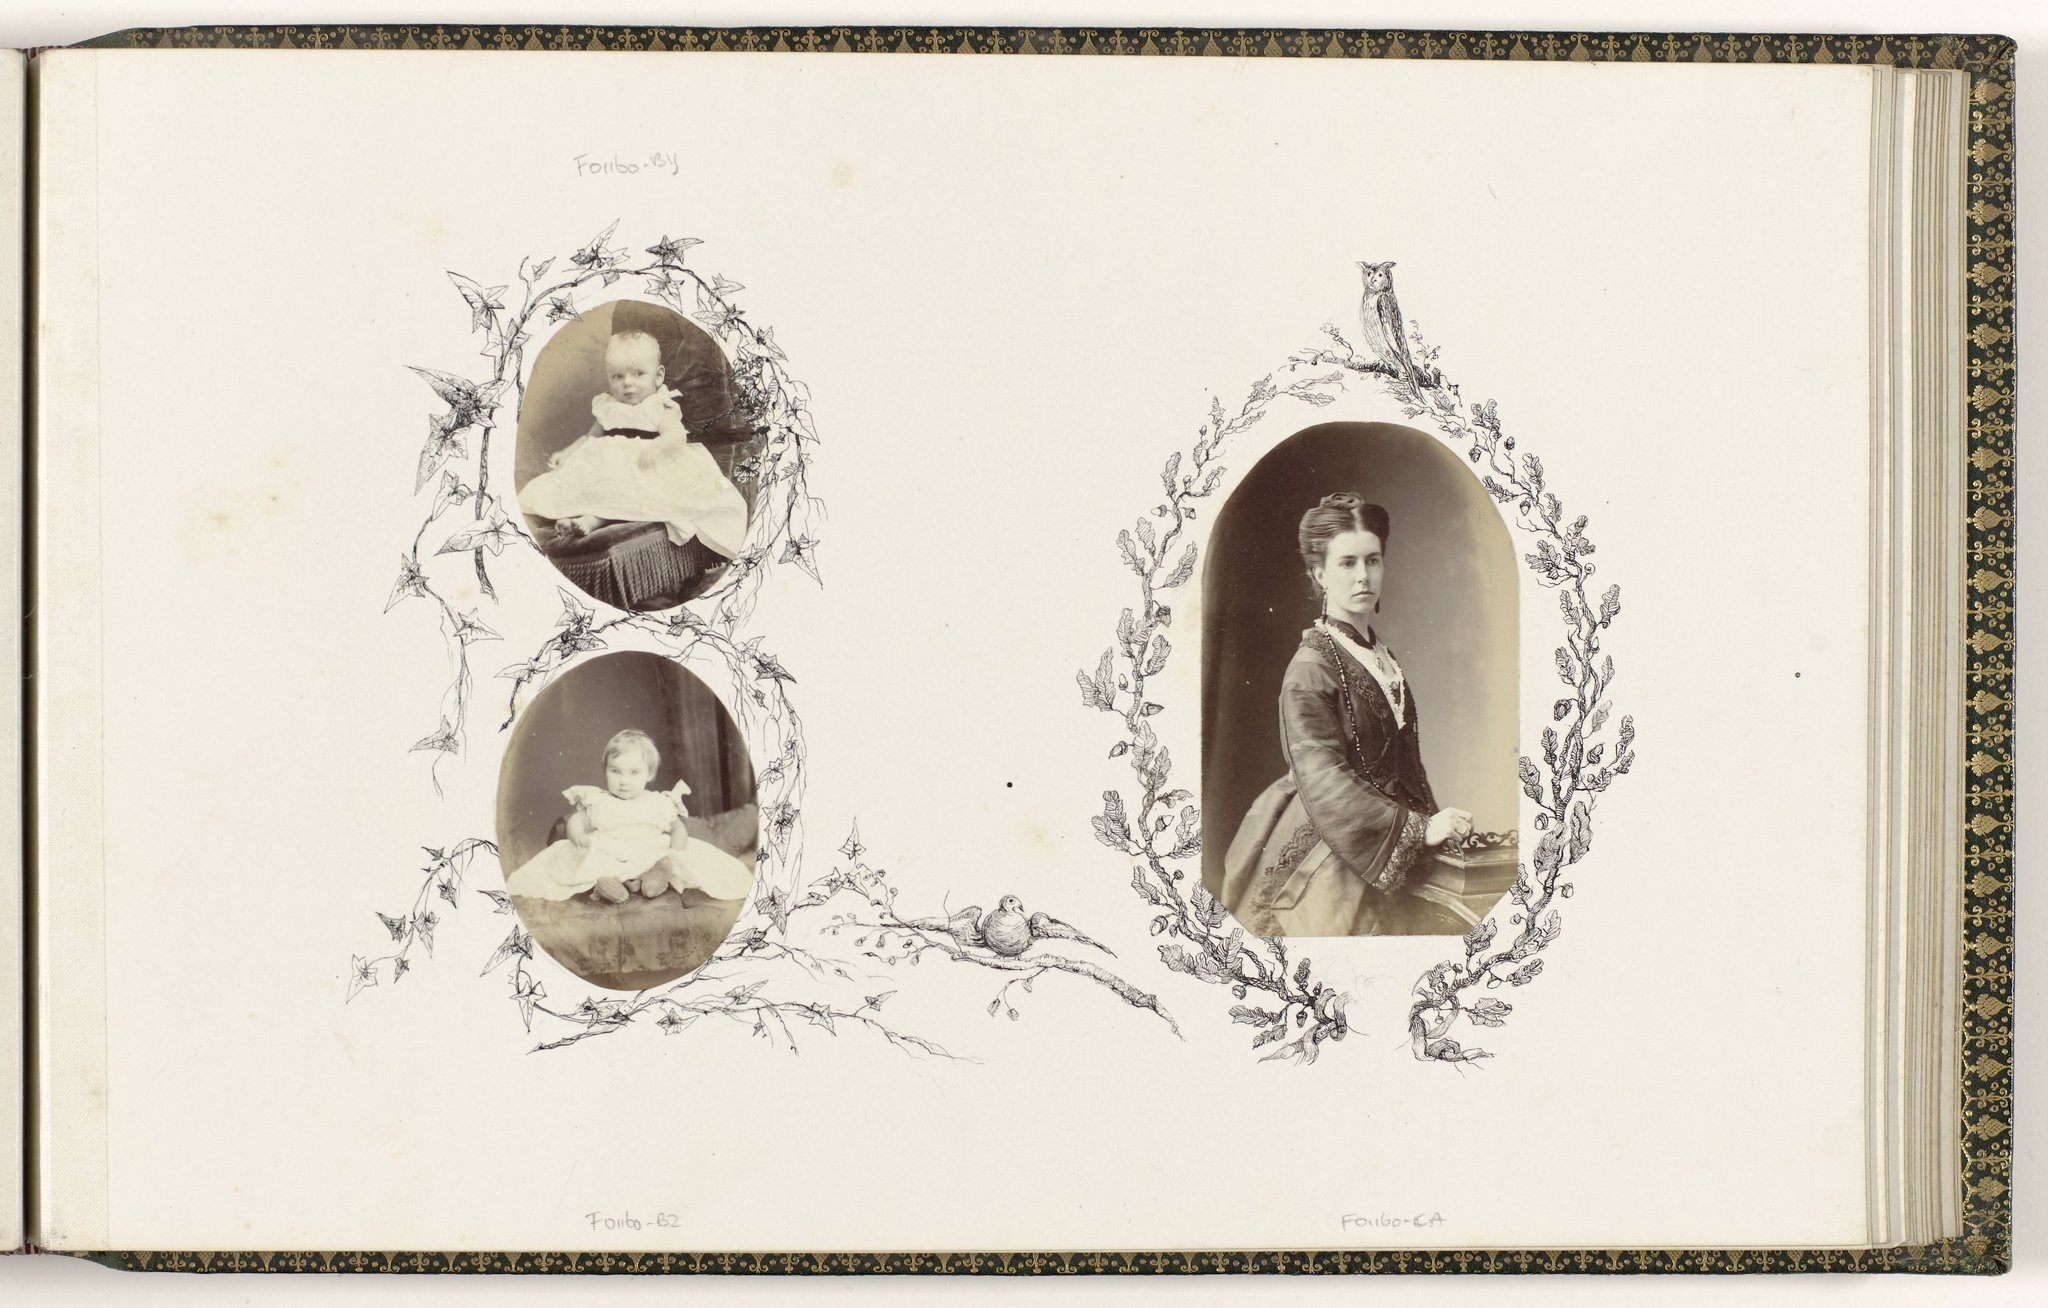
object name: album leaf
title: Portret van een onbekende vrouw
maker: Anonymous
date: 1870-1880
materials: paper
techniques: albumen print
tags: historical persons - bb - woman